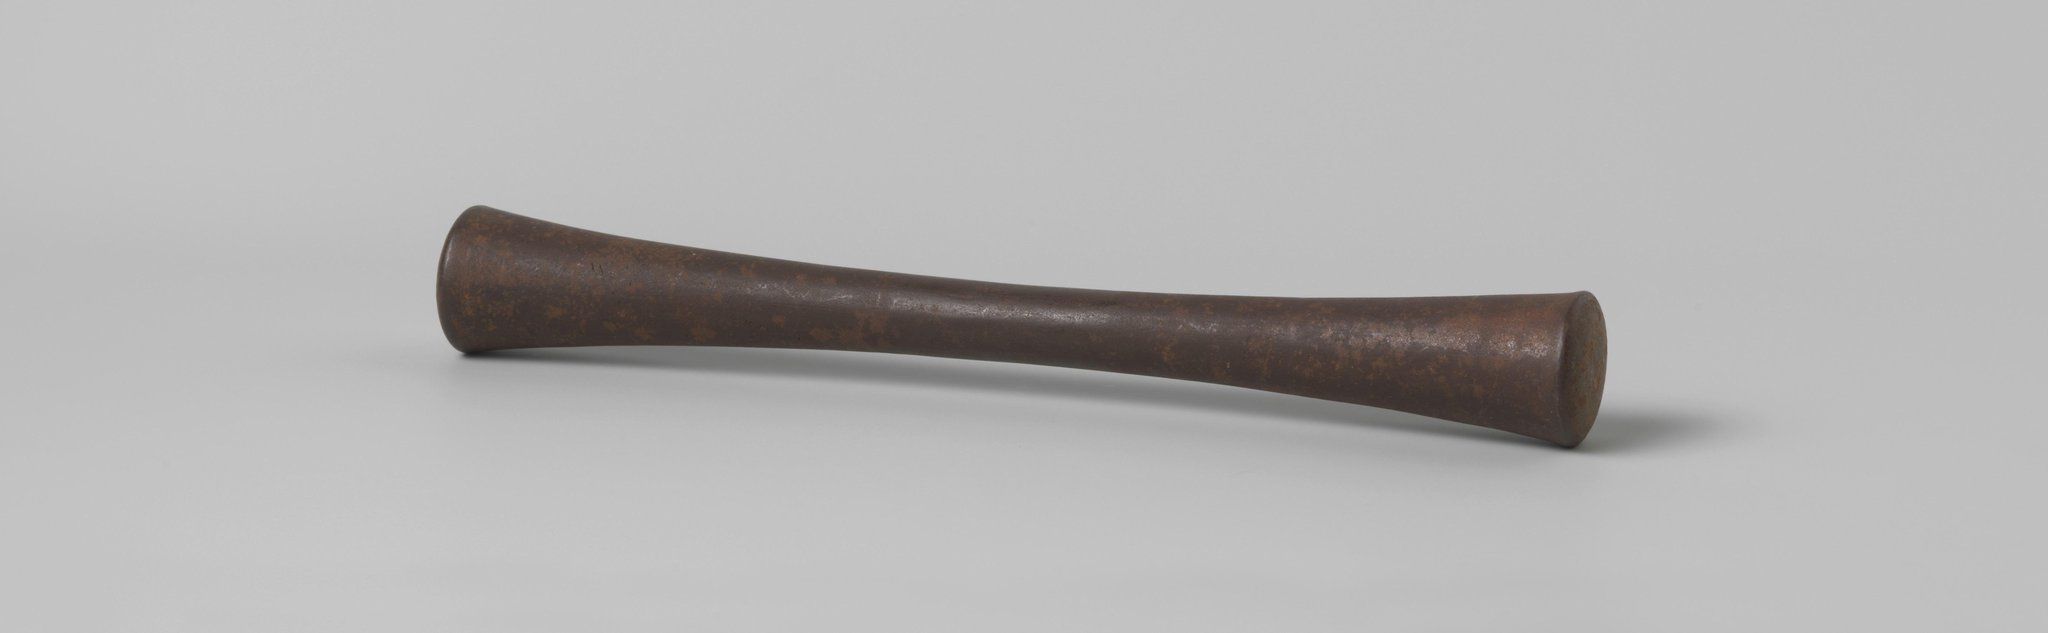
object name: beater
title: Mortar and Pestle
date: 1637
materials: iron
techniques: casting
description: This mortar is adorned with two friezes. The top one consists of stylized flowers, while the bottom one features flowers, foliage motifs, and birds with spread wings. Inscribed in Latin along the top edge is: ‘By the grace of God, Ouderogge made this in 1637.’ The mortar was cast by either Cornelis or his brother Dirk. They also made bells and cannons.